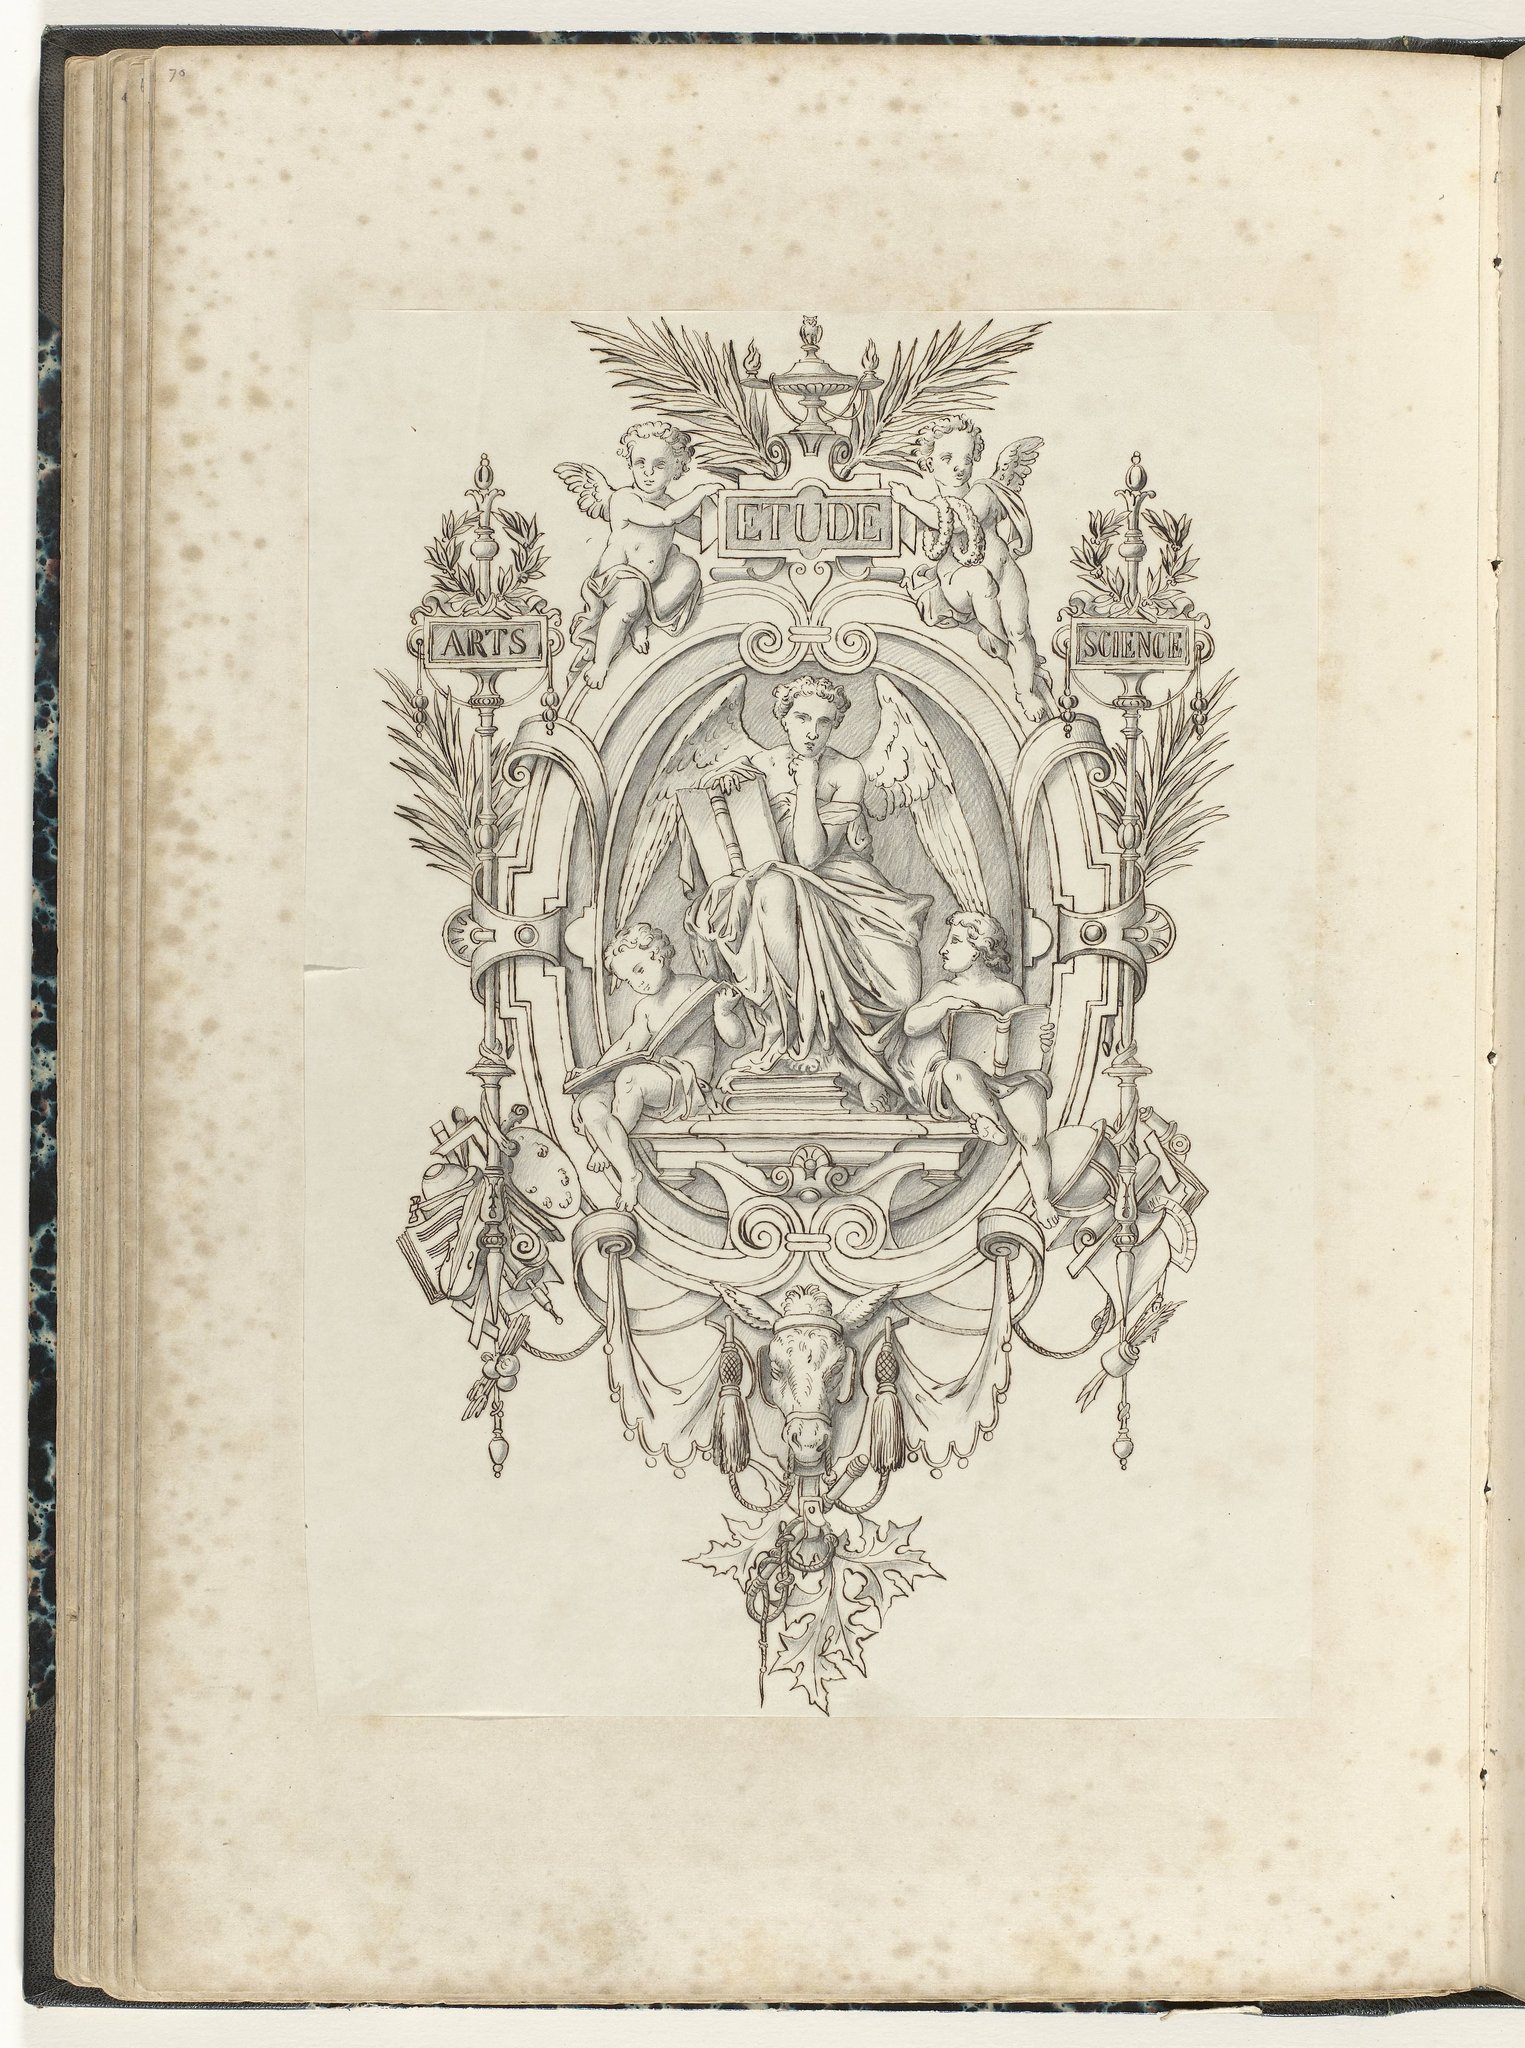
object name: drawing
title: Cartouche met gevleugelde vrouw en twee lezende kinderen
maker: Anonymous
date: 1866-1900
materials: ink, pencil, paper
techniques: drawing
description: Links van de cartouche hangt een trofee met kunstattributen, rechts een trofee met wetenschapsattributen. Bovenaan staan de volgende woorden in kleine cartouches: Arts, Etude en Science.